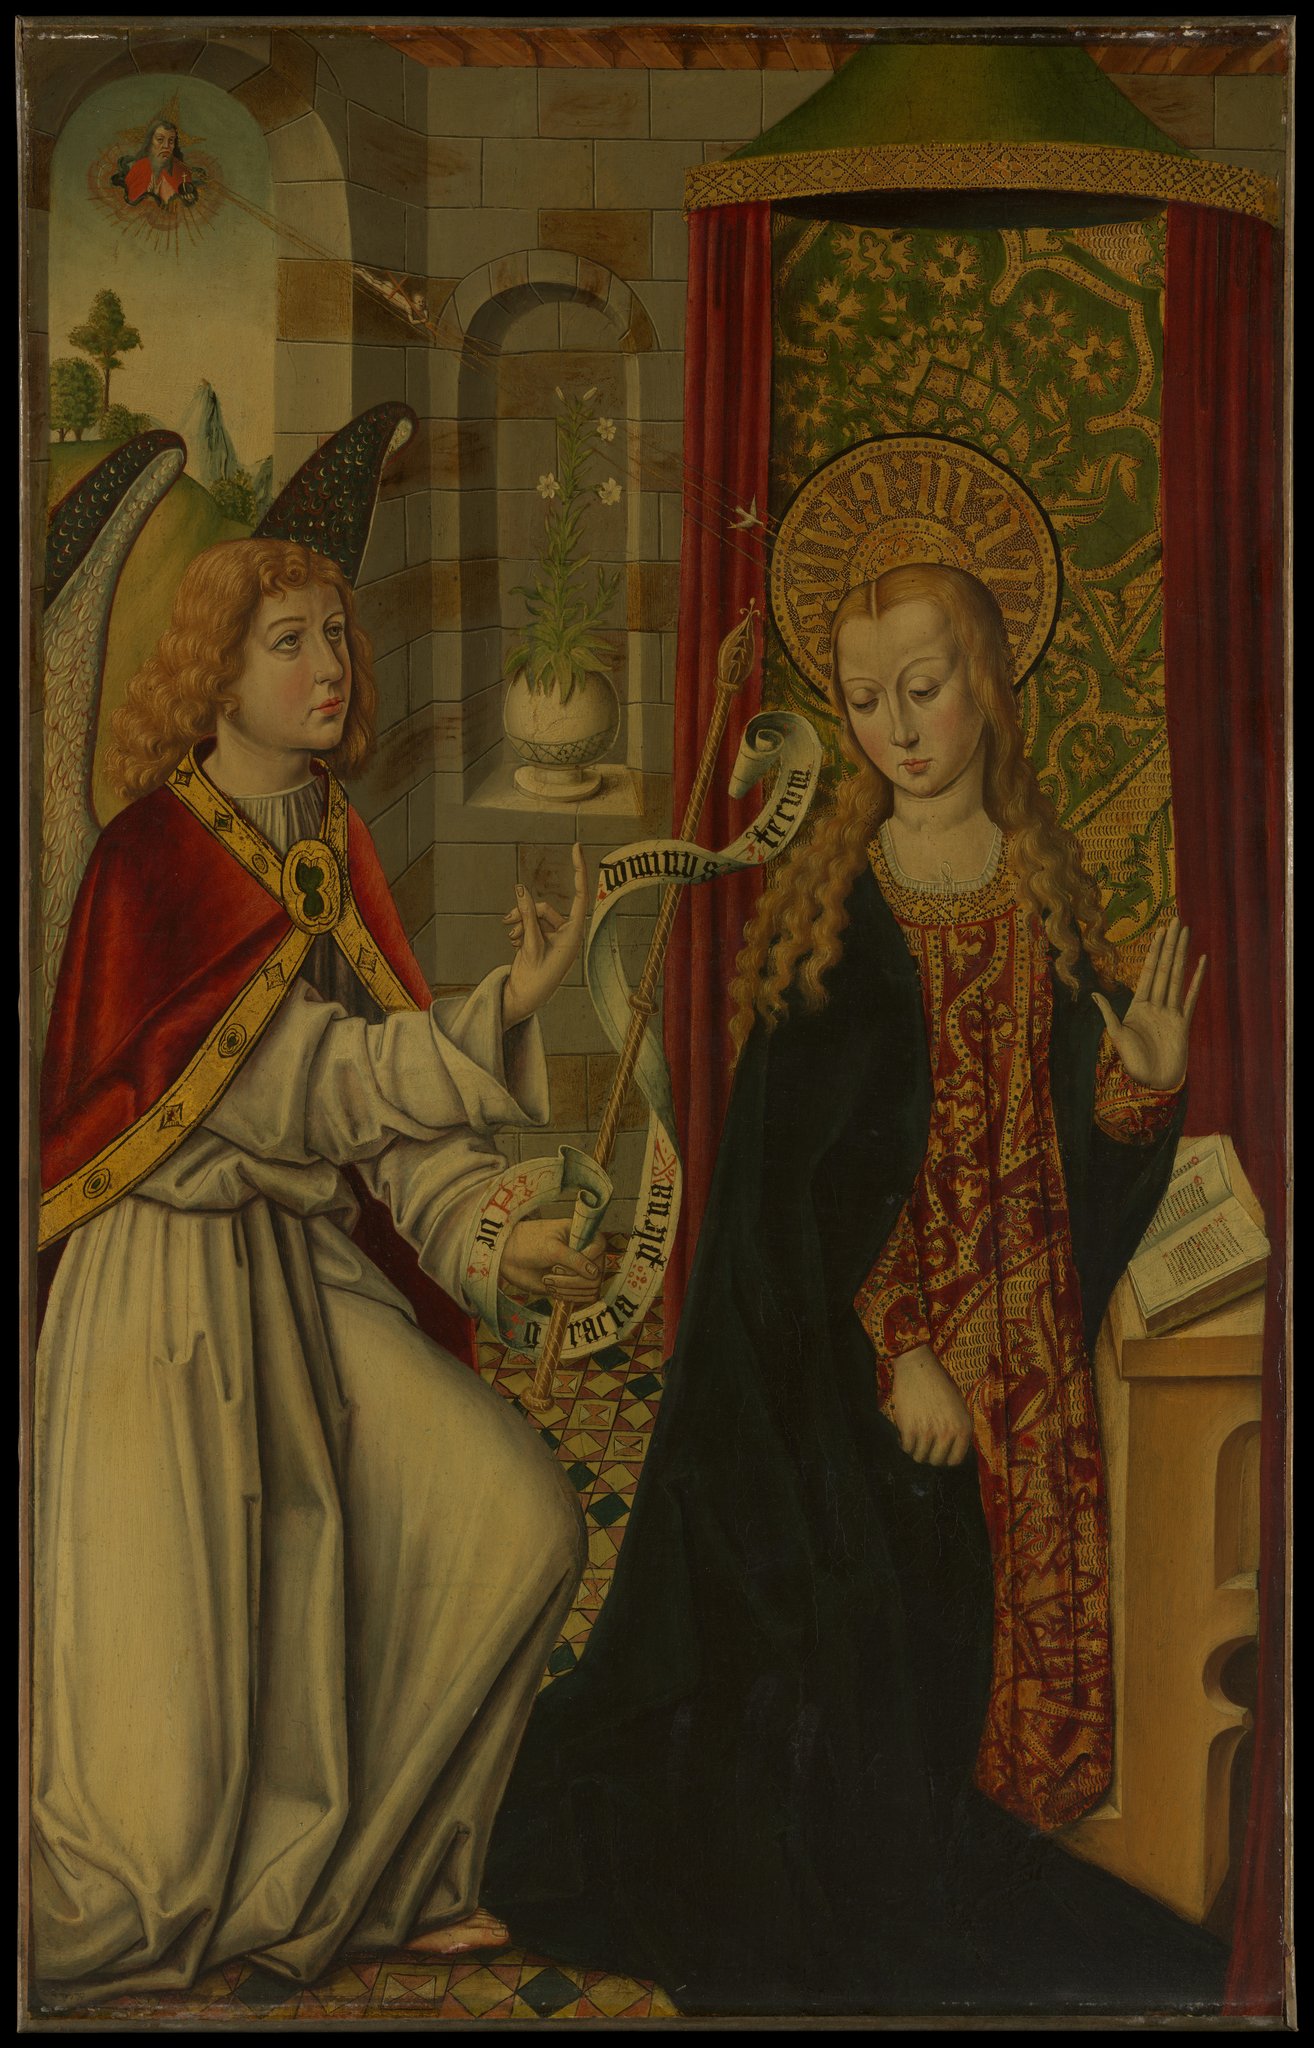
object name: painting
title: The Annunciation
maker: budapest master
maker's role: artist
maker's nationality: spanish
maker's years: 1500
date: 1495-1505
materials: canvas, gold, oil, wood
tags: virgin mary,archangel gabriel,annunciation